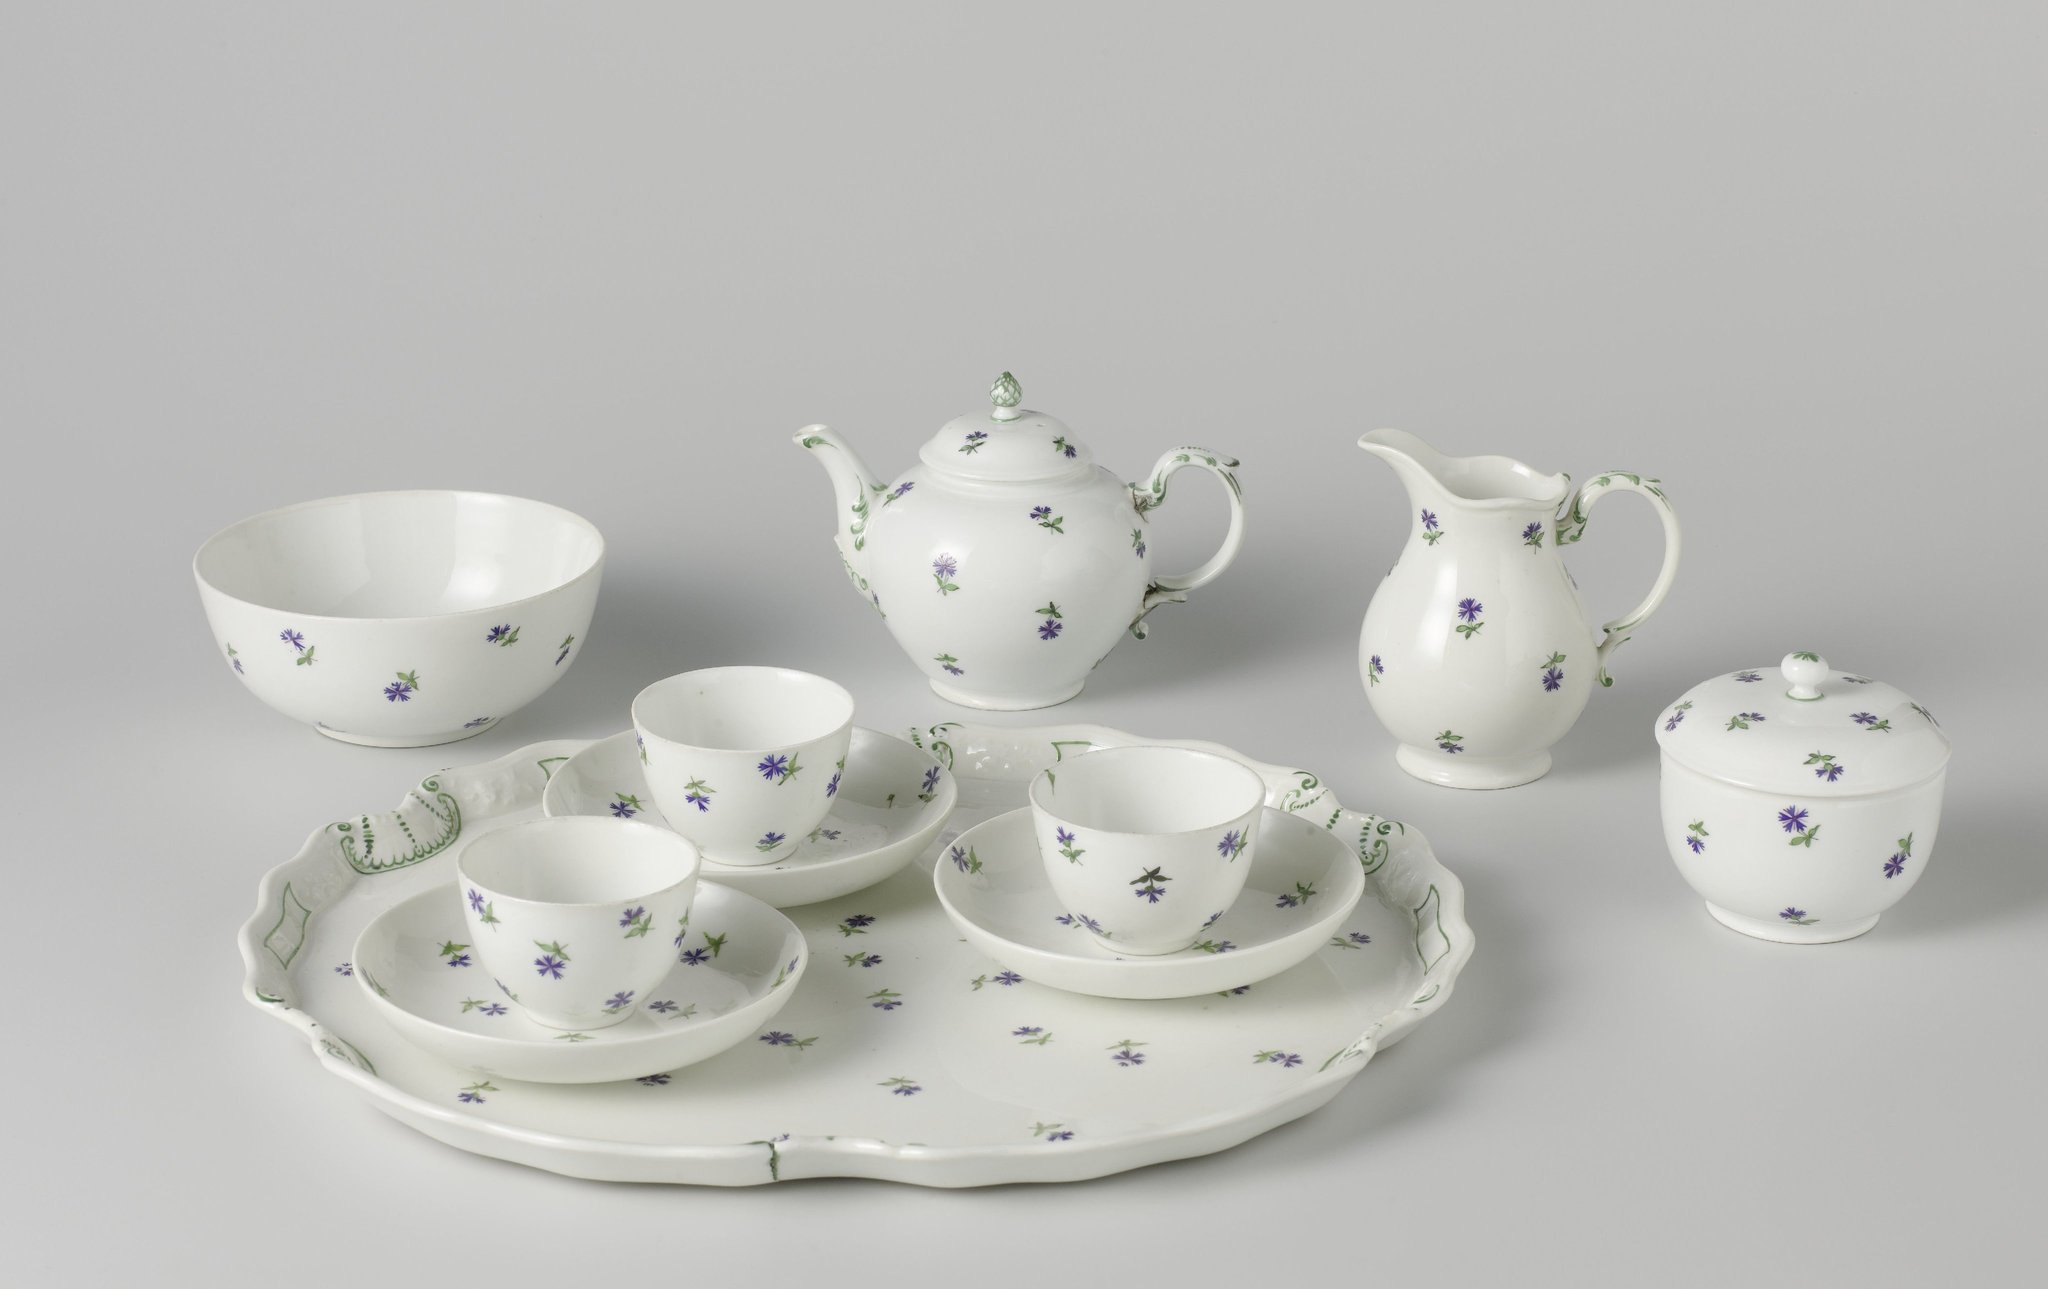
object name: tea service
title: Theeservies bestaande uit een blad, theepot, melkkan, suikerpot, spoelkom en elf koppen en schotels, beschilderd met korenbloemen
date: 1784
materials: porcelain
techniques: painted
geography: loosdrecht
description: Tea service on tray. Porcelain. Loosdrecht and Ouder-Amstel, c. 1782 - 1790. Factory under the direction of Friedrich Daeuber.